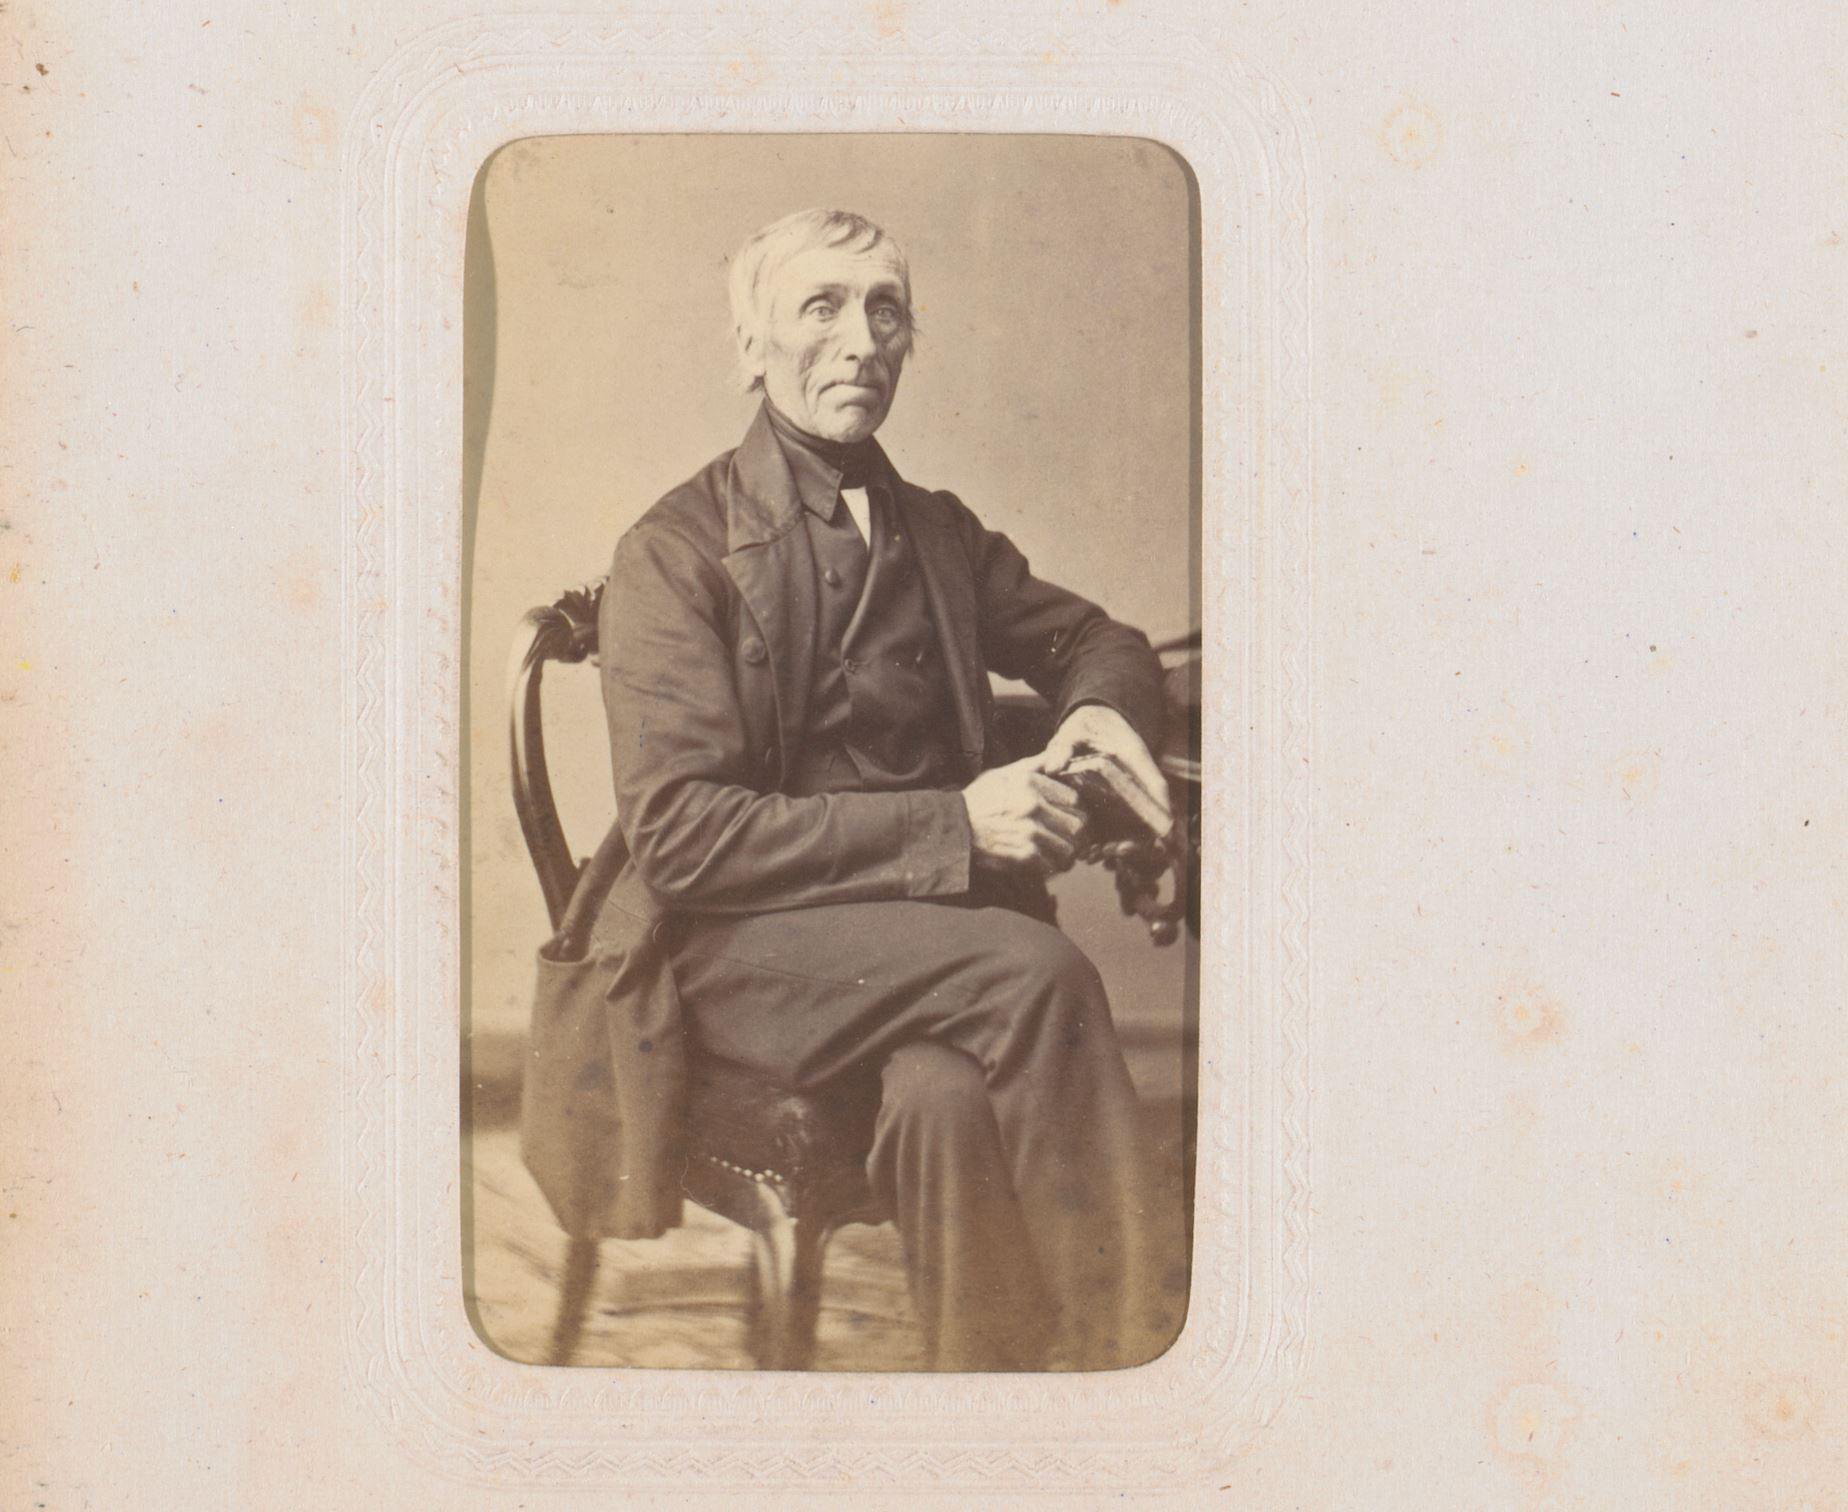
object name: carte de visite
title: Portret van een zittende man met boek in de hand, aangeduid als Van der Haven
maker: kornelis willem schorteldoek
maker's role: boekbinder, fotograaf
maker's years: 1800-1885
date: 1855-1885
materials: cardboard, photographic support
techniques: albumen print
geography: gorinchem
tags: sitting figure, historical persons, book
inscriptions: name: ‘v. d. Haven’, inscription: ‘SCHORTELDOEK/ PHOTOGRAAF/ GORINCHEM/ Groote Markt’